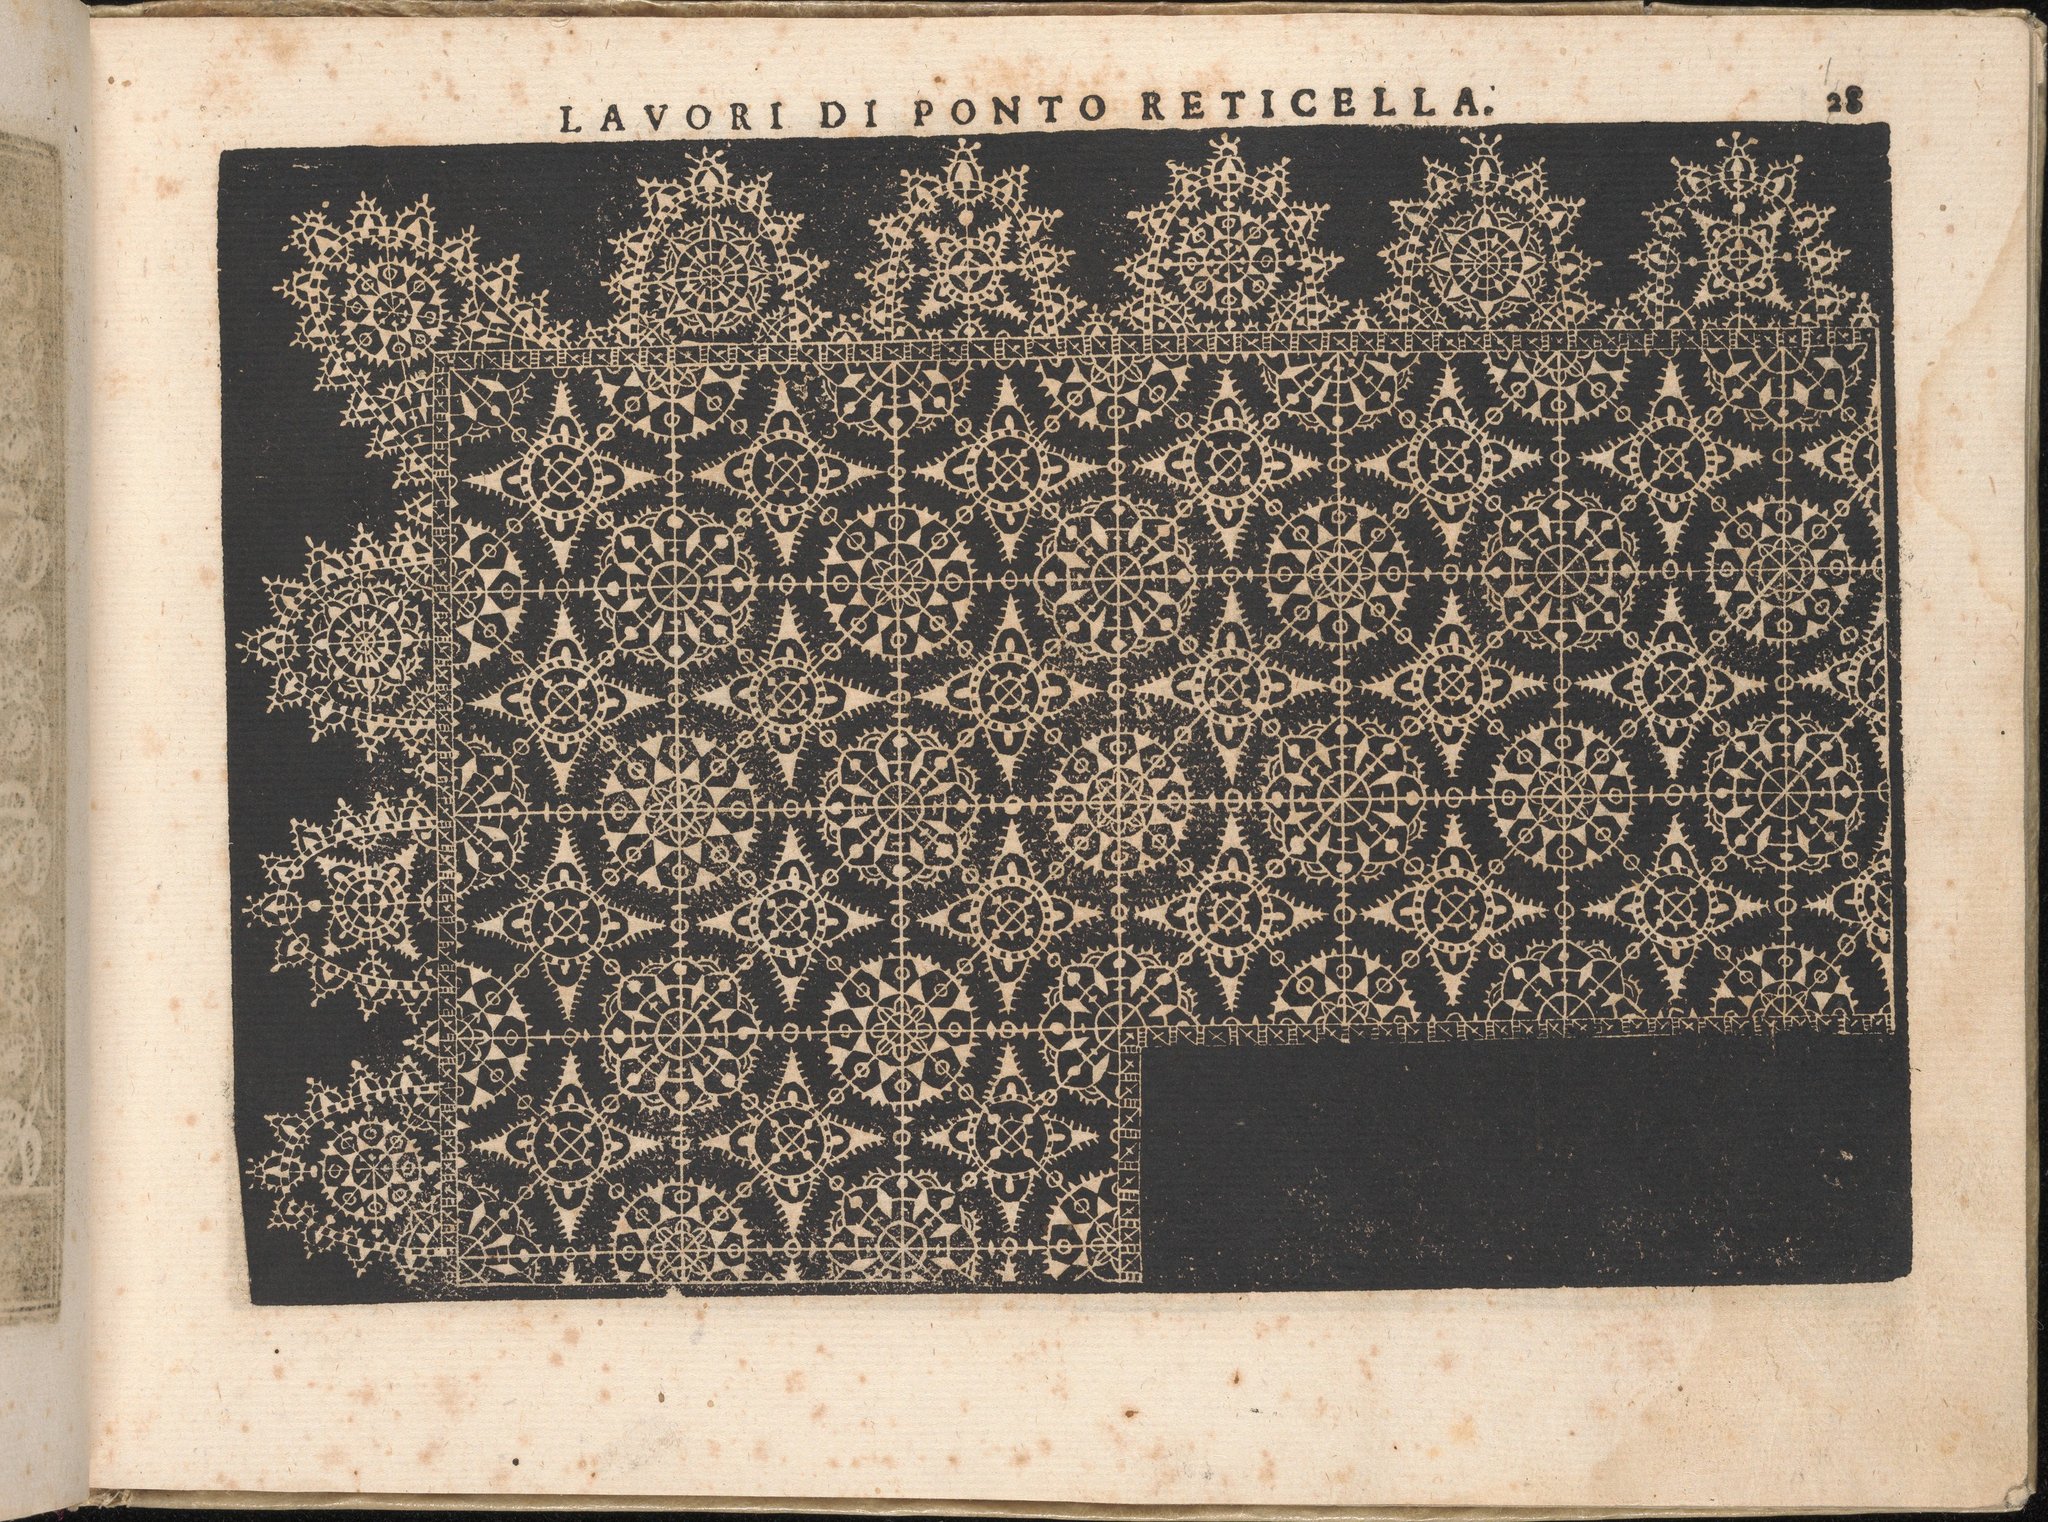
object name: book print ornament architecture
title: Fiore D'Ogni Virtu Per le Nobili Et Honeste Matrone, page 18 (recto)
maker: isabella catanea parasole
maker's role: designer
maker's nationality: italian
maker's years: 1565-1625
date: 1610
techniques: woodcut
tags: ornament